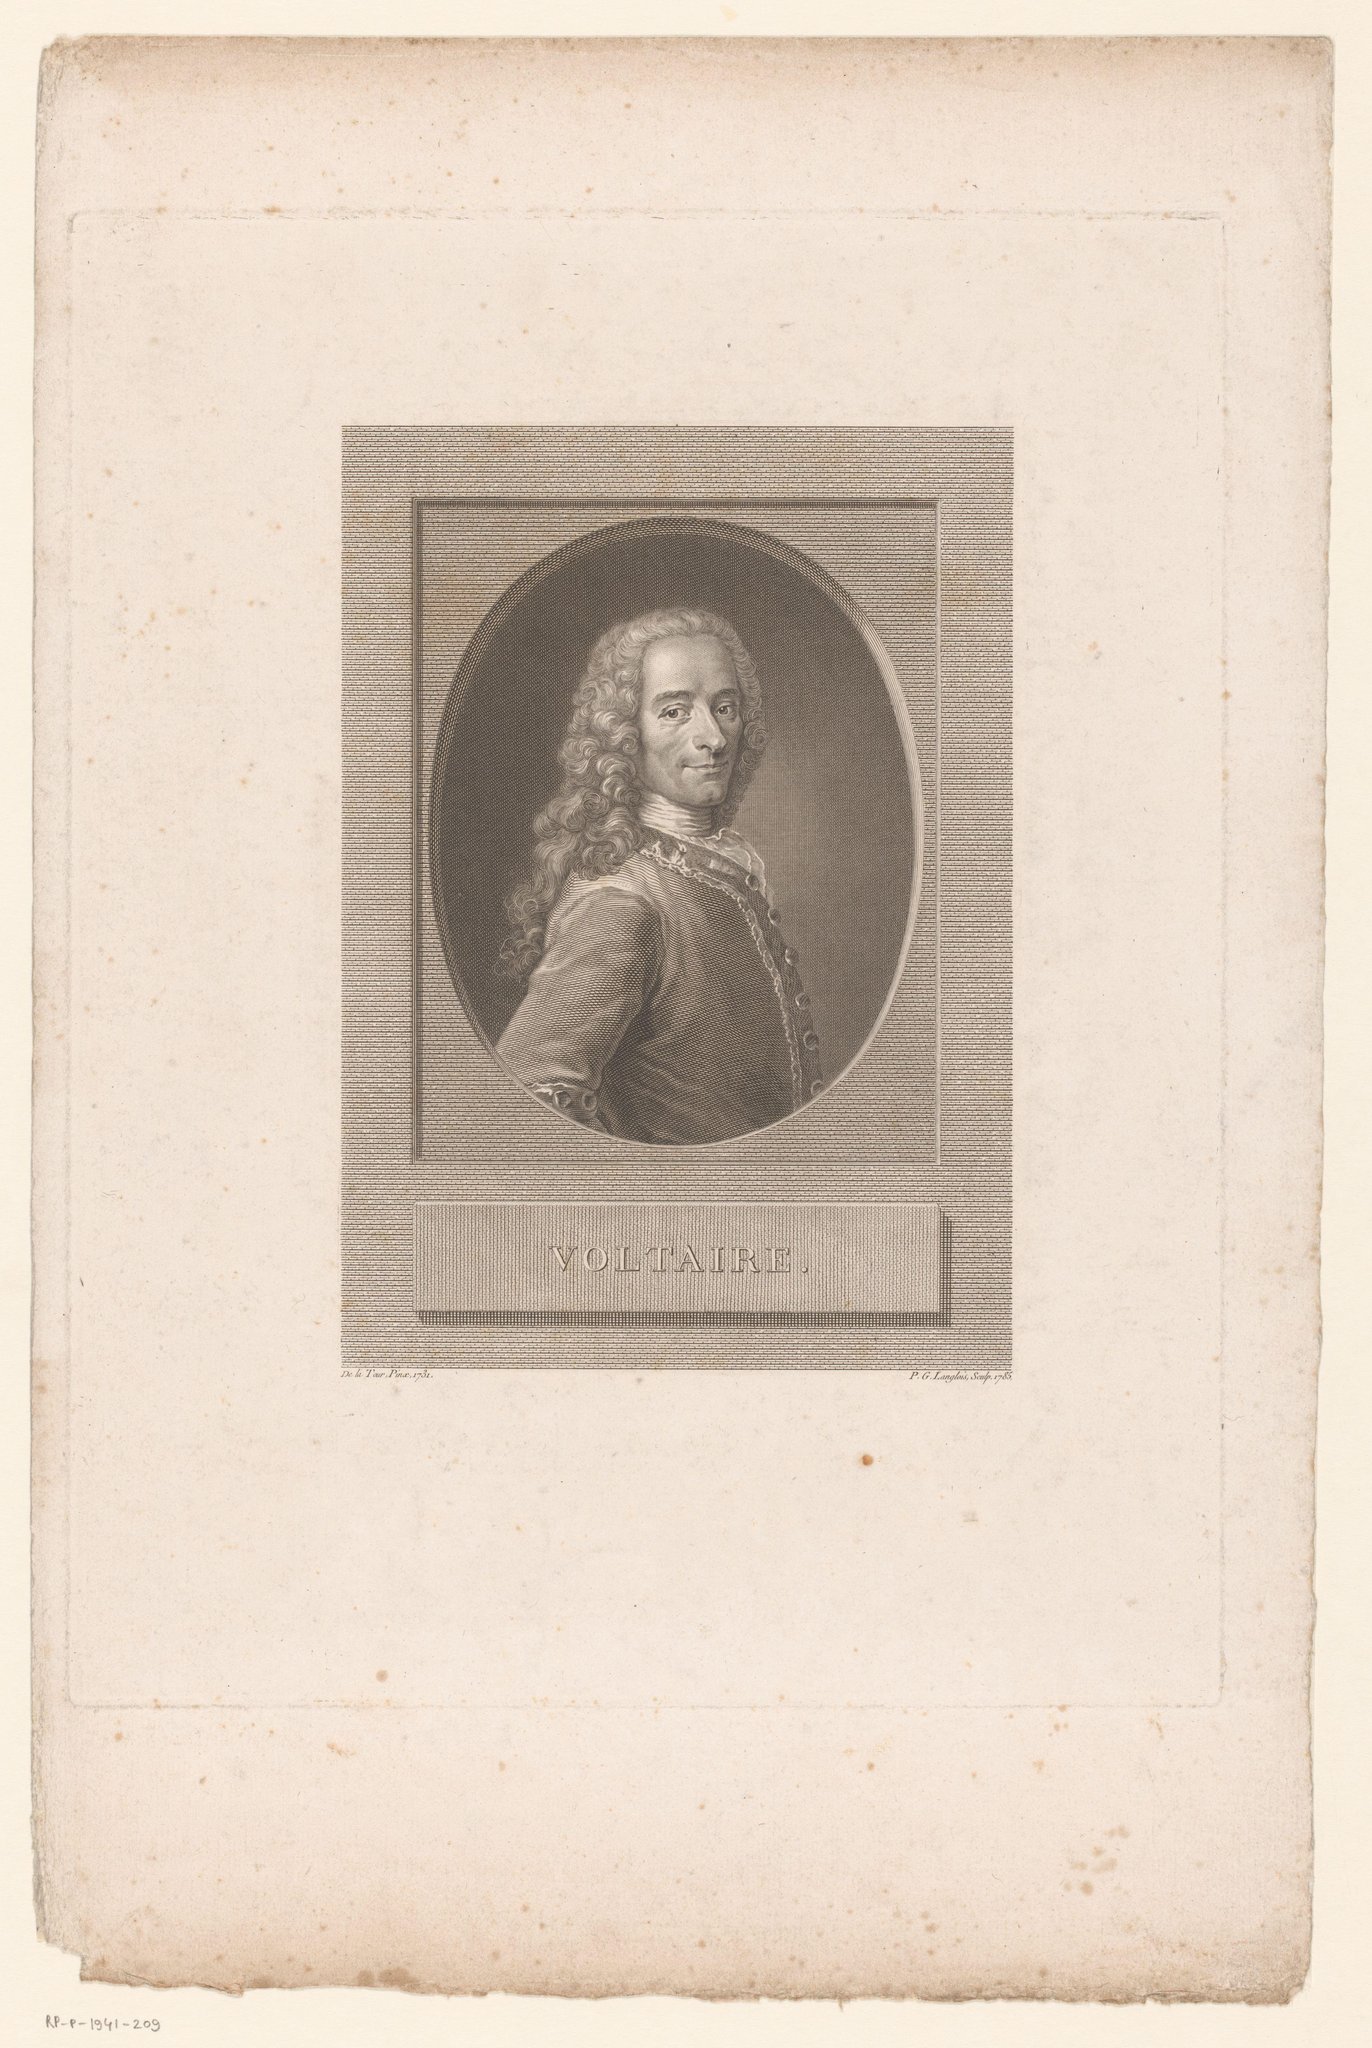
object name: print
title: Portret van Voltaire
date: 1785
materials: paper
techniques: engraving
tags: paris, voltaire, historical persons, portrait of a writer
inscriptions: collector's mark: Lugt 2760, collector's mark: Lugt 2228